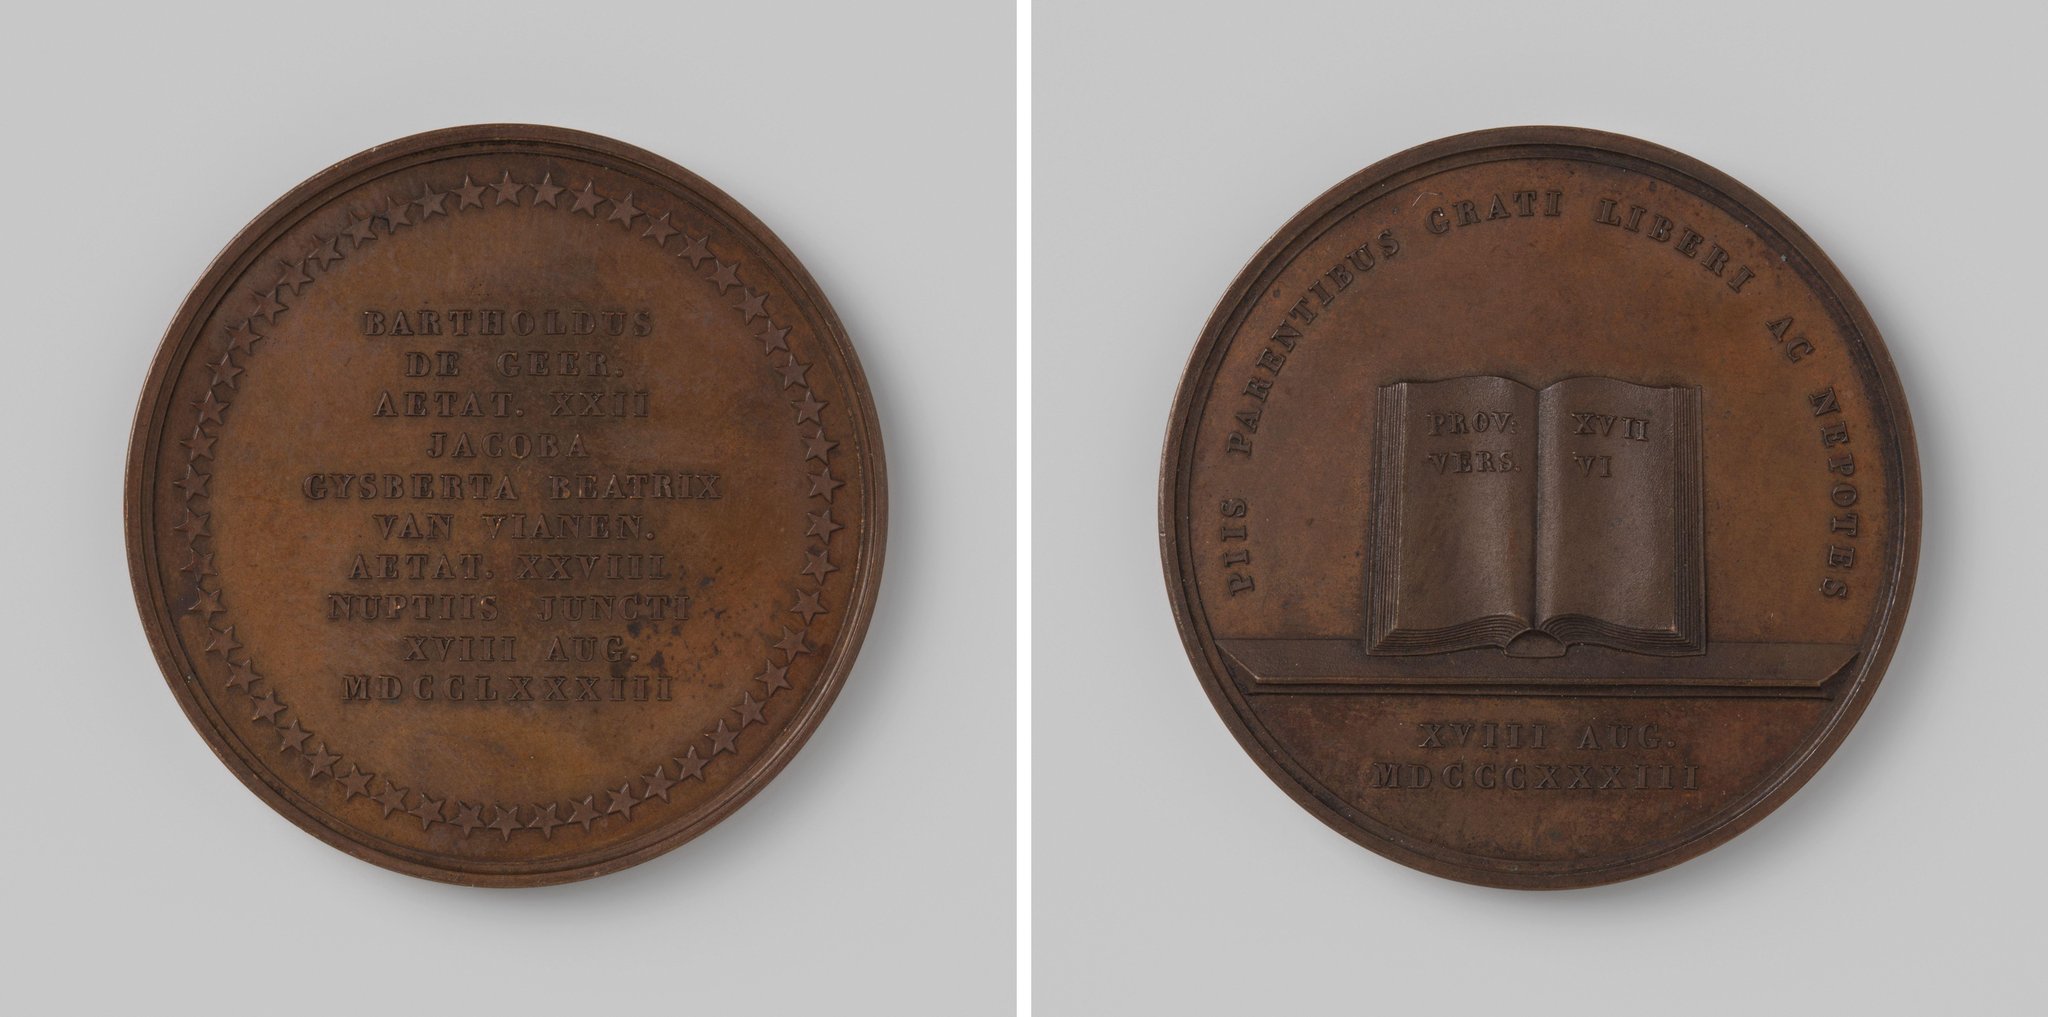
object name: family medal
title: Vijftigjarig huwelijk van Barthold de Geer, heer van Jutphaas en Johanna Gisbertha Beatrix van Vianen, penning aangeboden door kinderen en kleinkinderen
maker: Anonymous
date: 1833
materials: bronze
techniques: striking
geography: utrecht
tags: utrecht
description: Bronzen penning. Voorzijde: opschrift binnen sterrekrans. Keerzijde: staande, geopende bijbel met opschriftbinnen omschrift; afsnede: opschrift